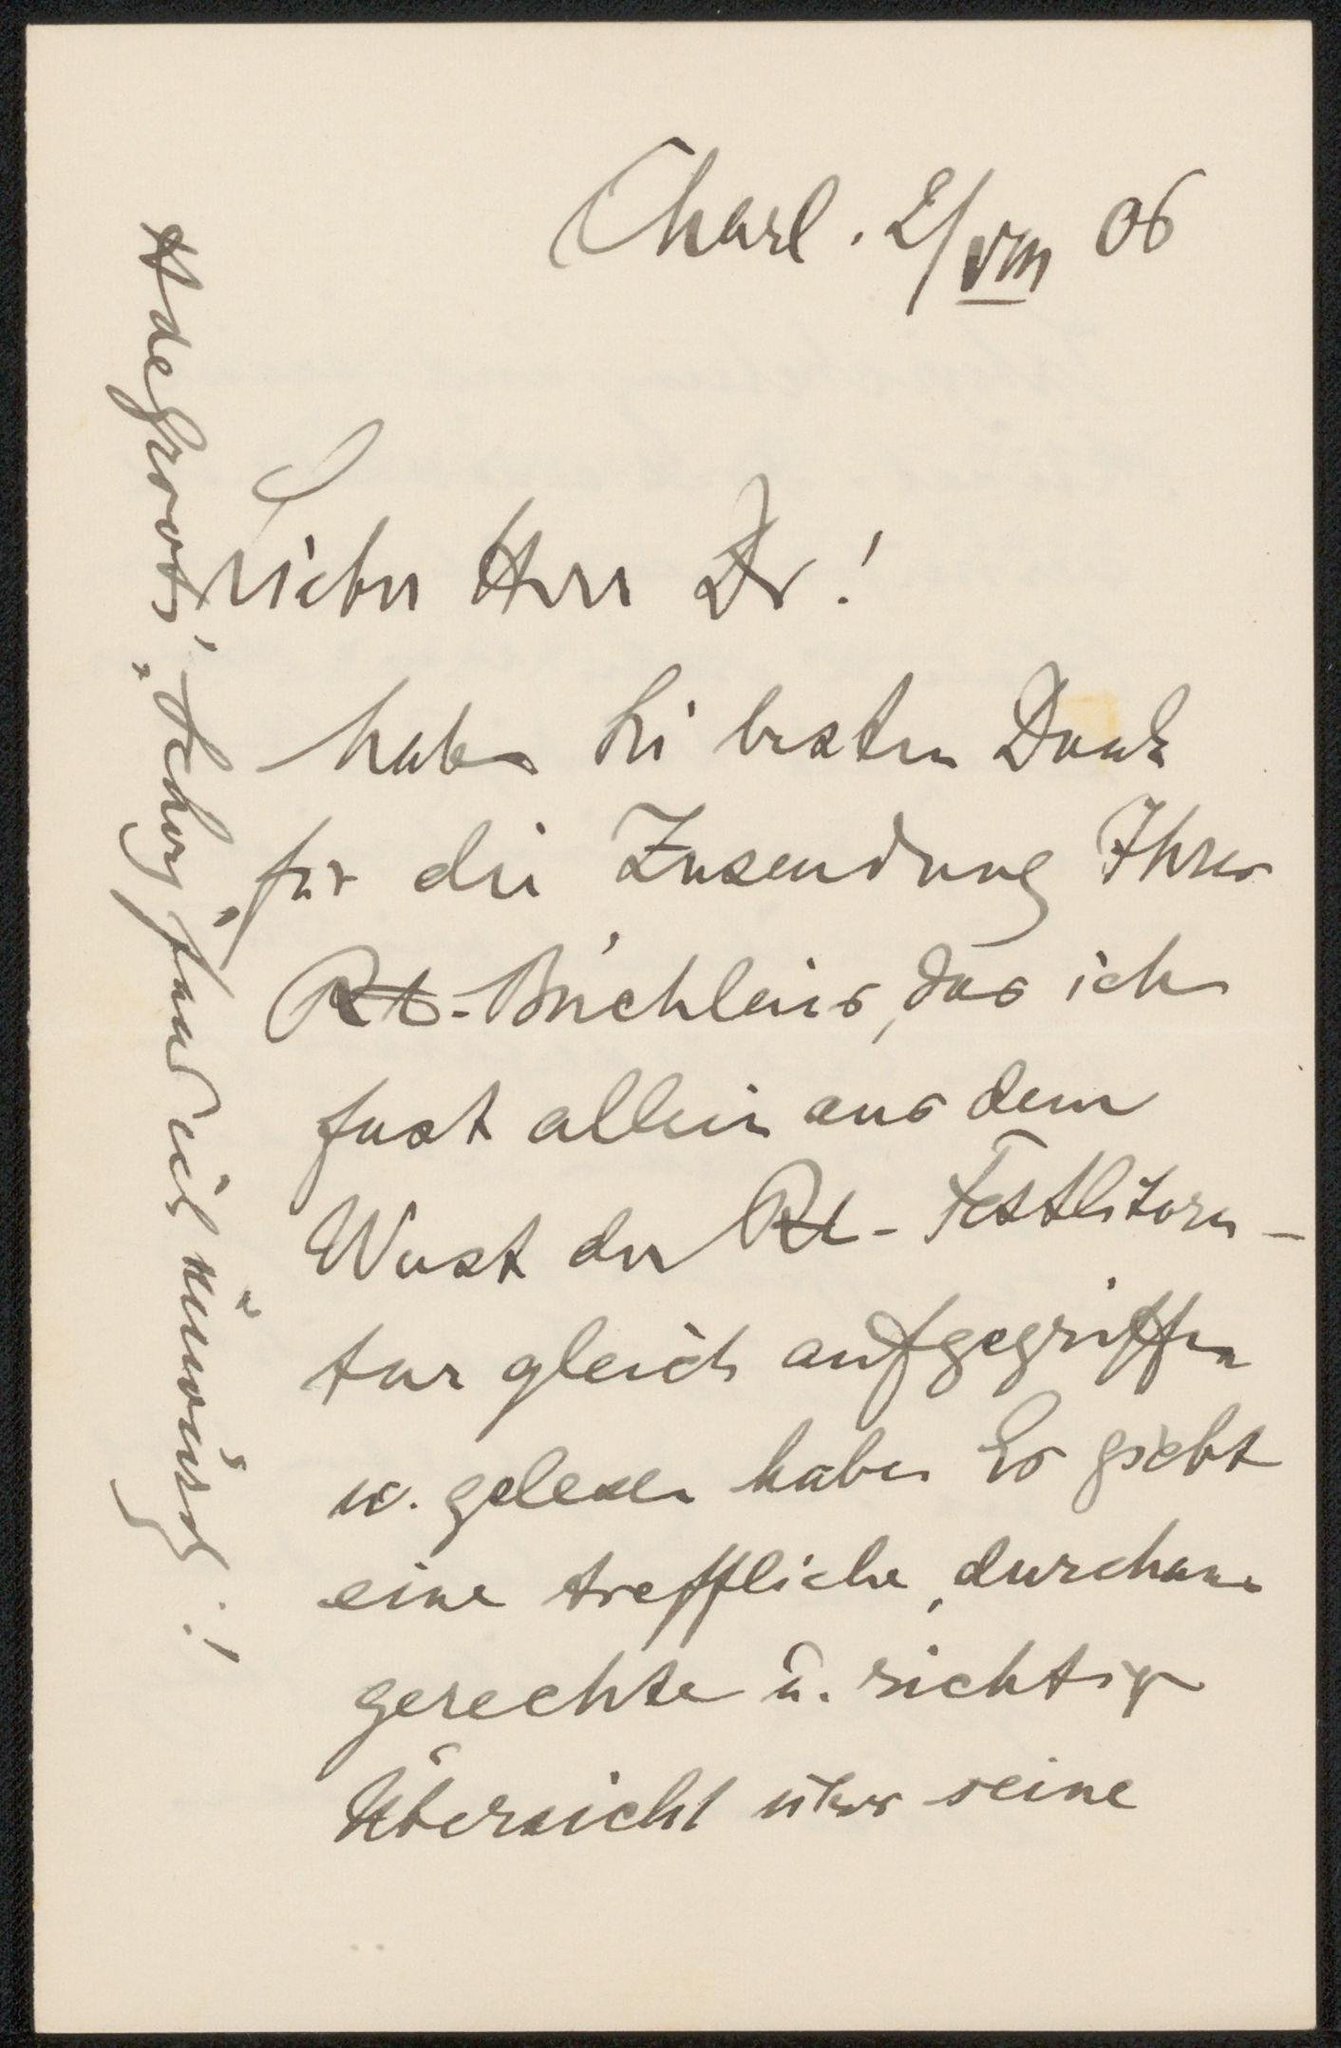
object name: letter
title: Brief aan Jan Veth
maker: wilhelm von bode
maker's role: conservator, kunsthistoricus, museumdirecteur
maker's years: 1845-1929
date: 1906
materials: ink, paper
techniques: pen, printing, writing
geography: charlottenburg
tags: dordrecht, painter, print maker, draughtsman, designer, jan veth, abraham bredius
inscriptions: collector's mark: ‘RPK’